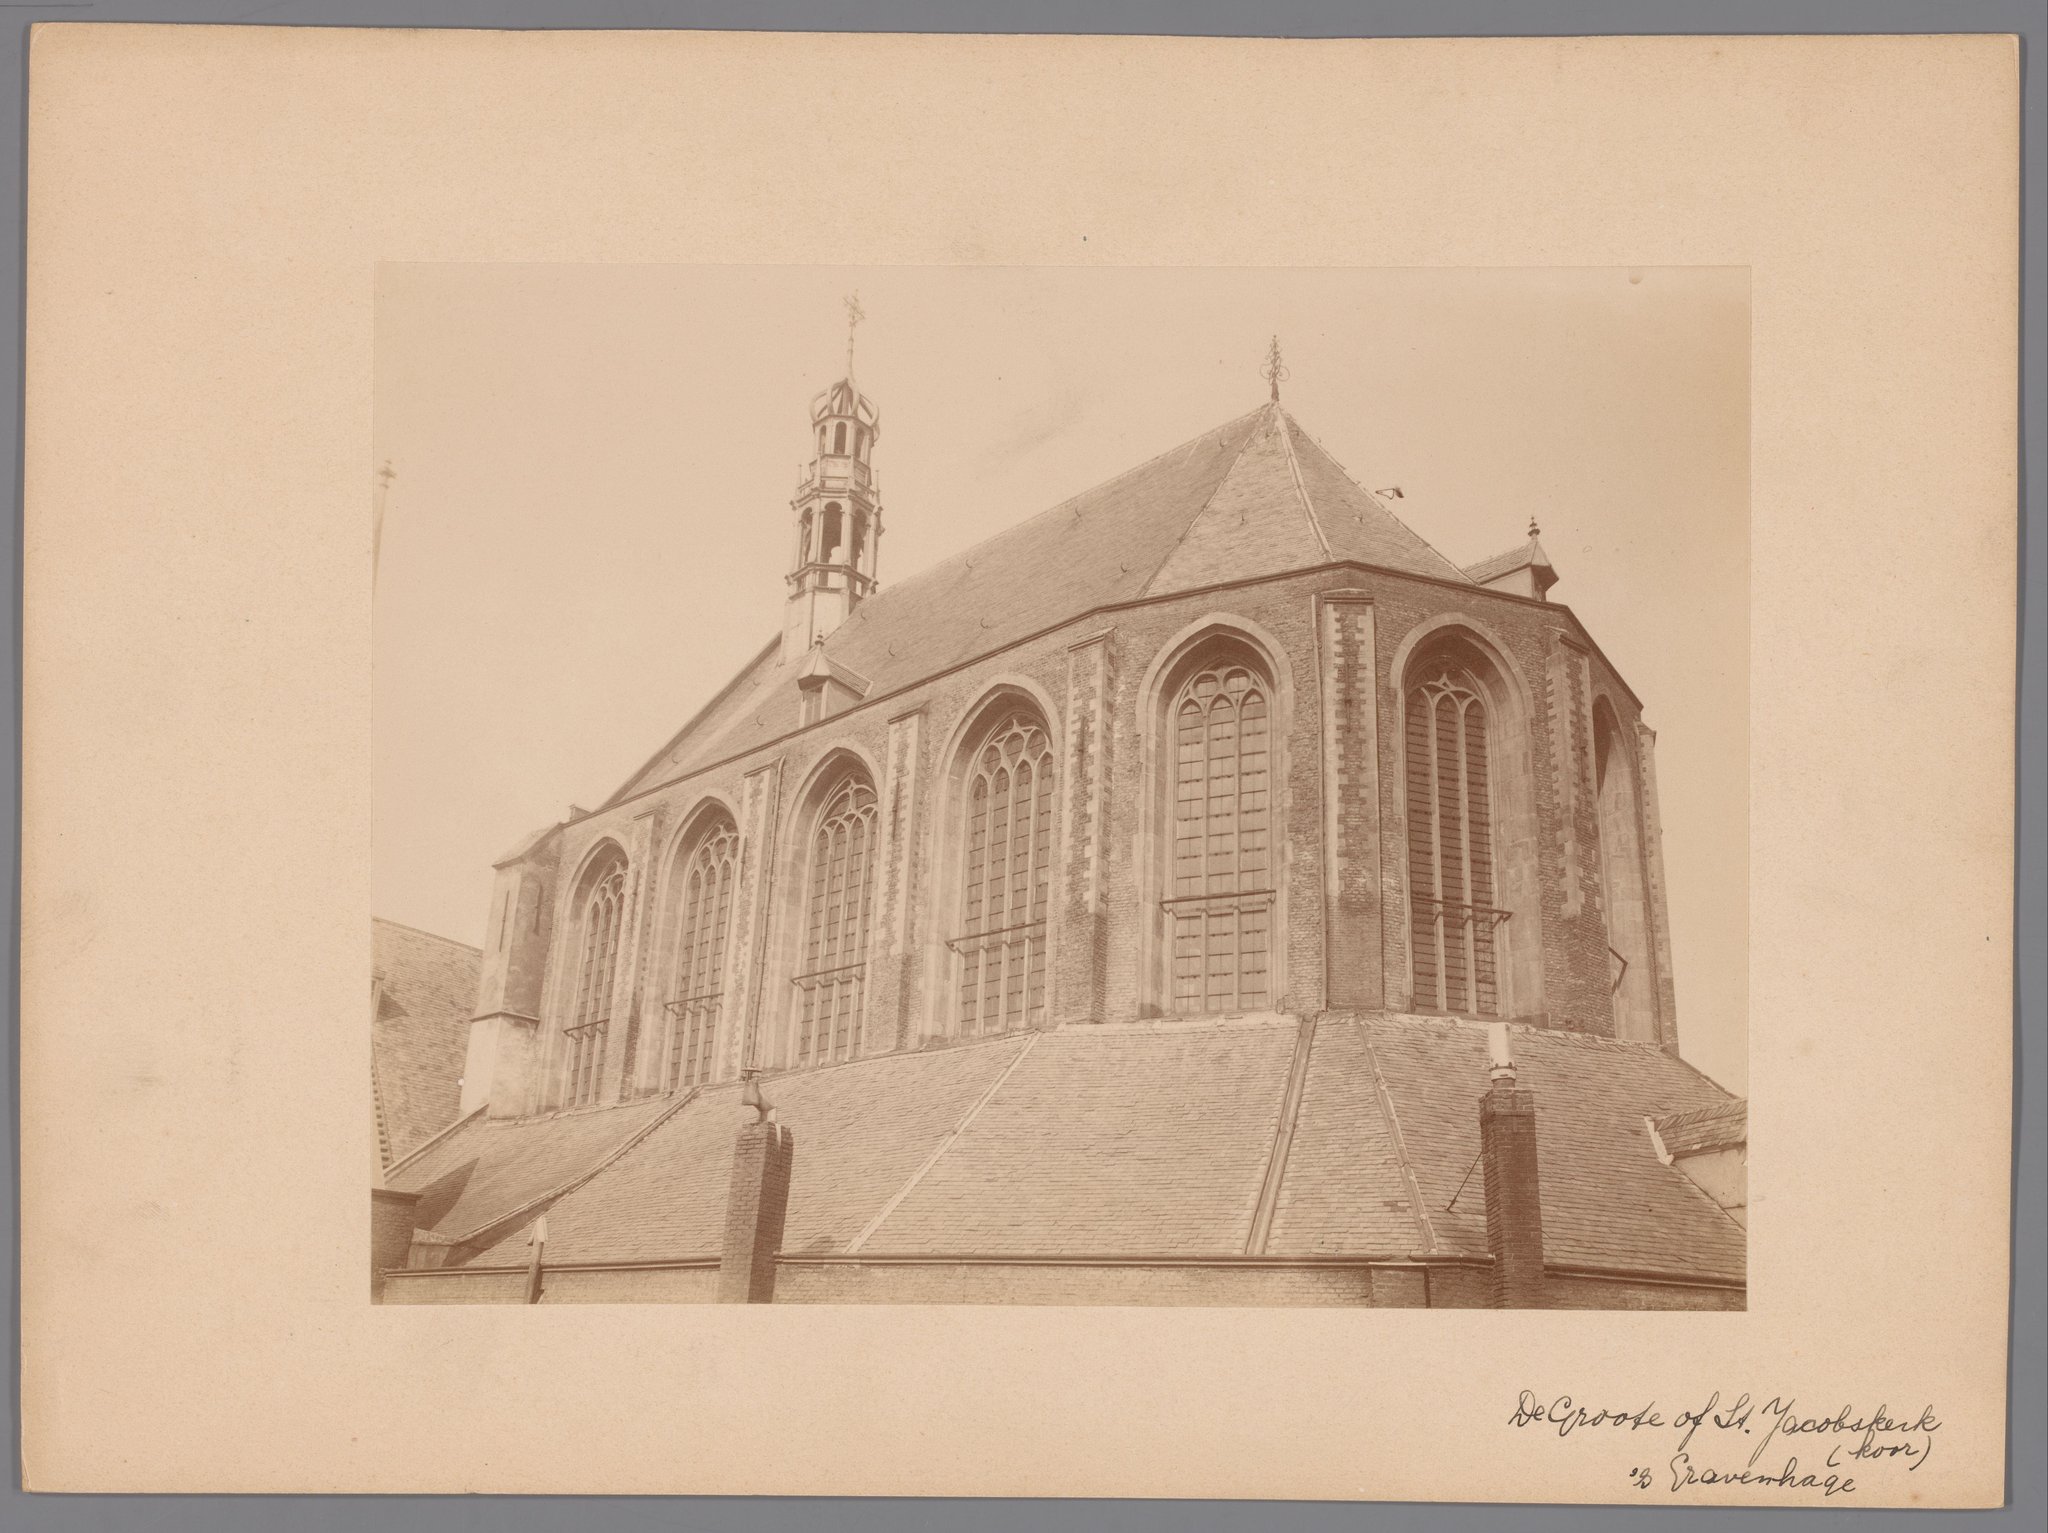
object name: photograph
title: Koor van de Grote of Sint-Jacobskerk te Den Haag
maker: anoniem (monumentenzorg)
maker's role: fotograaf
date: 1890-1920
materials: cardboard, photographic support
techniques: albumen print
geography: the hague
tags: church (exterior)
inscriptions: collector's mark: ‘R:MUS.’ Lugt 2228, annotation: ‘De Groote of St. Jacobskerk (koor) 's Gravenhage’, annotation: ‘S. Jacobskerk Haag/ Koor’